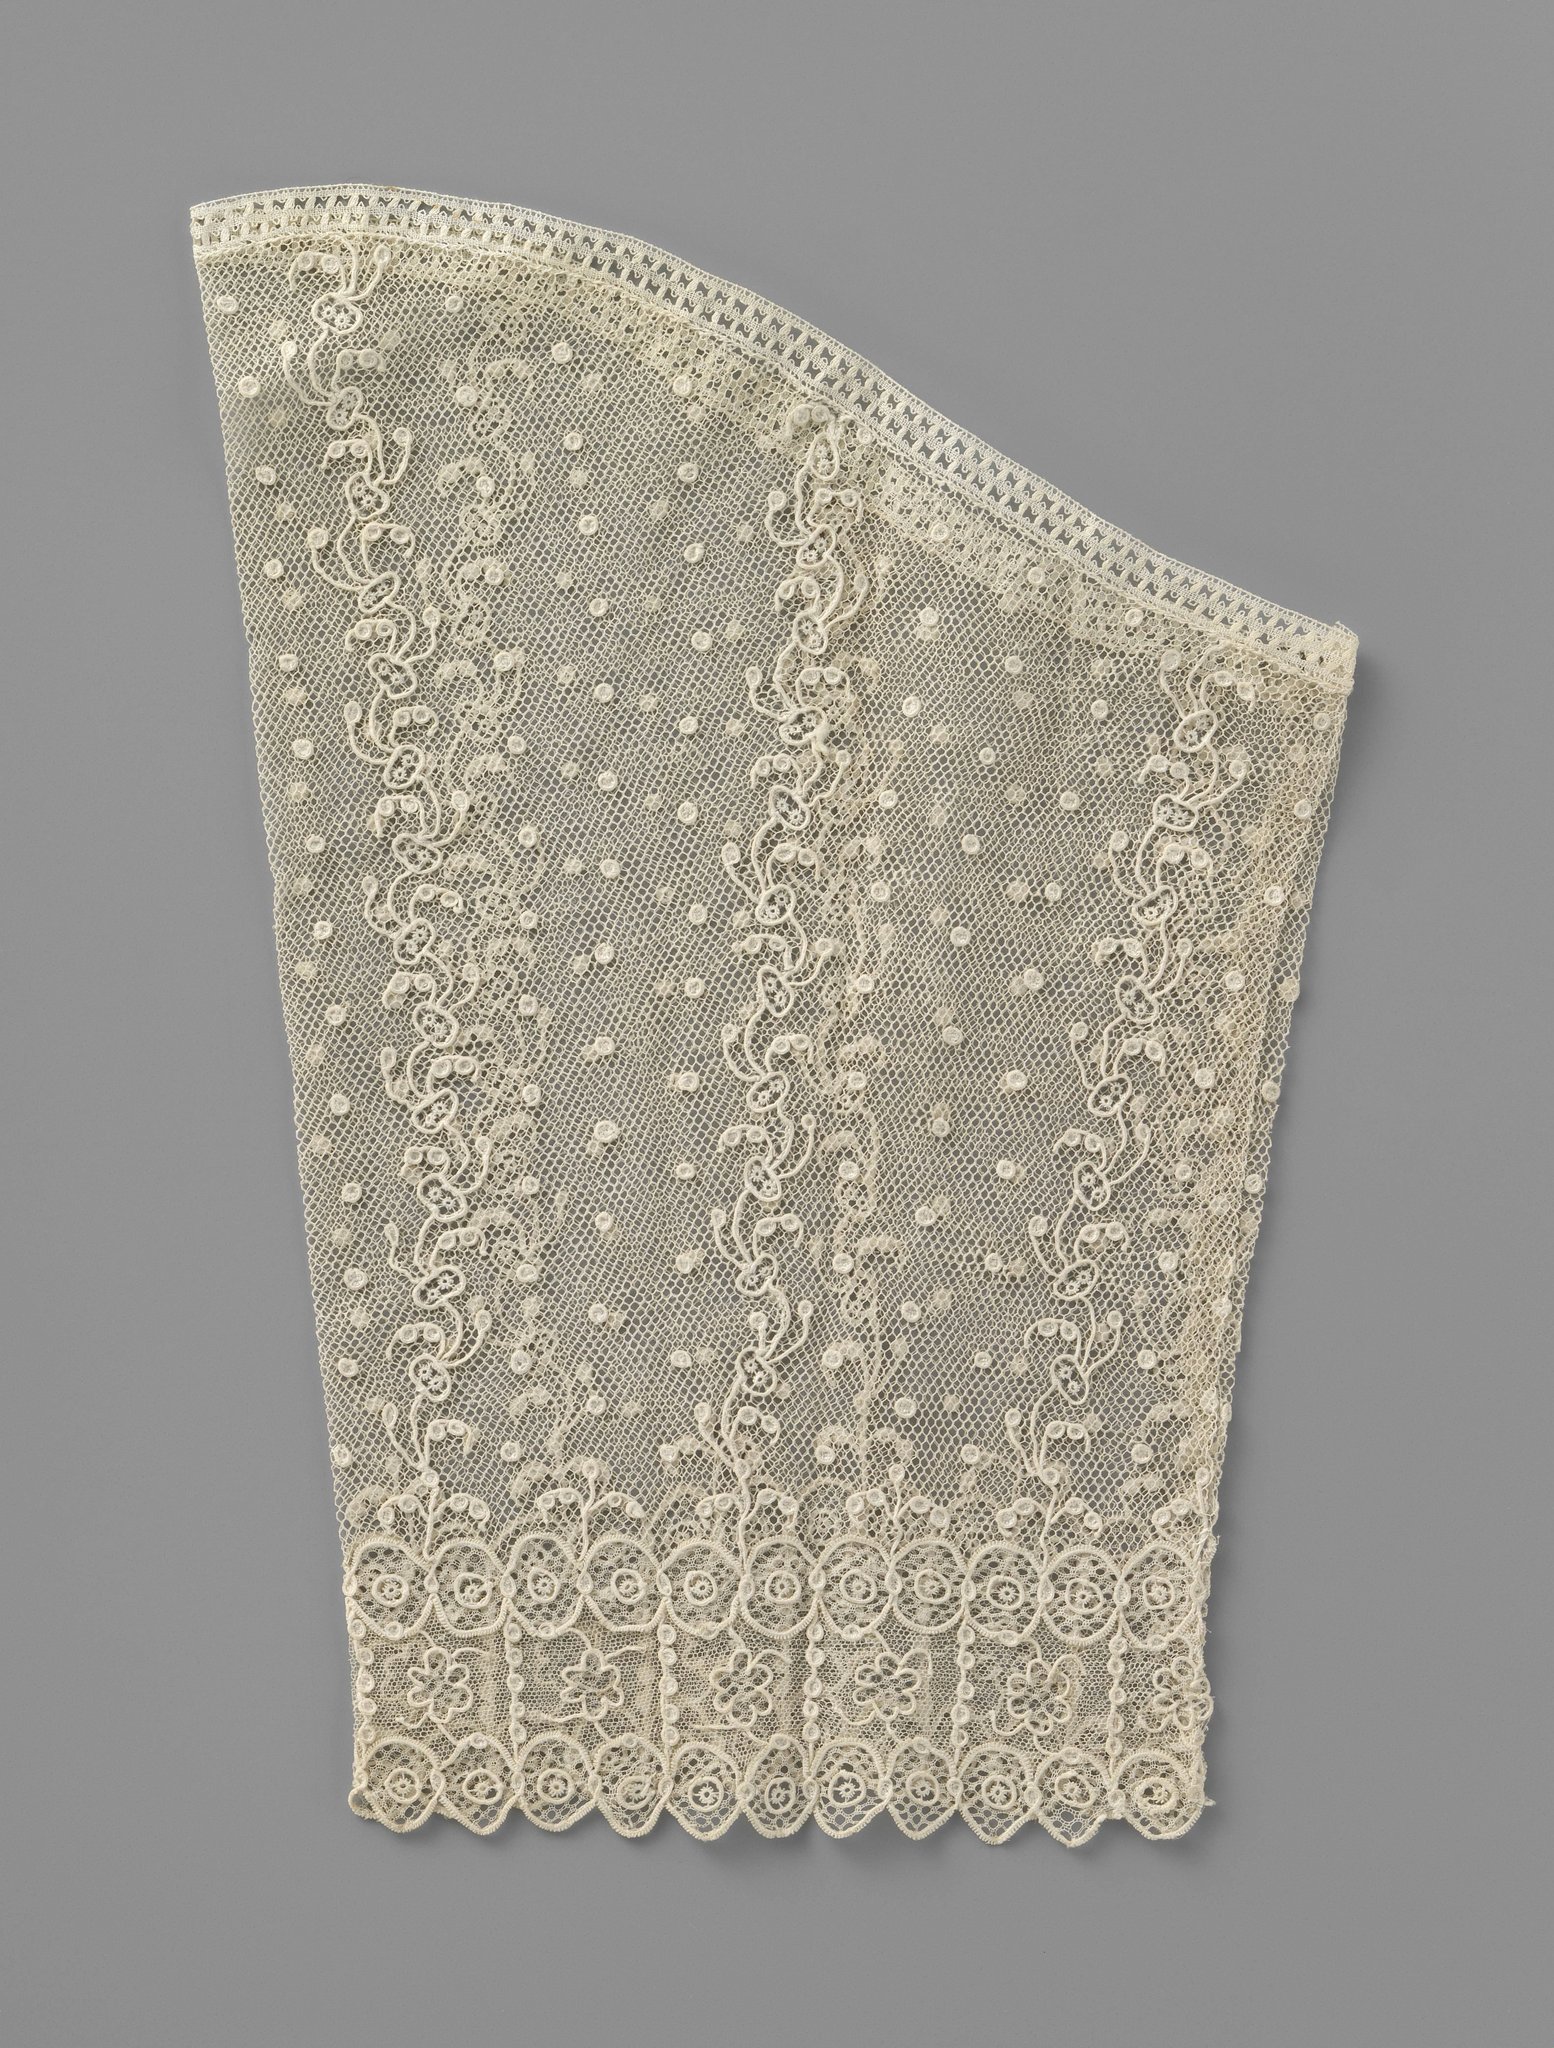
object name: sleeve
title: Mouw van naaldkant met streepjes en moesjes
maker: Anonymous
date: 1800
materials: linen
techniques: lace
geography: france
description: Korte en rechte coupe, smal toelopend naar de onderrand. Streepjes, gevormd door een slingerend takje met fijne knopjes wisselen af met tussenstroken, bezaaid met moesjes. Aan de benedenzijde loopt een dubbele rand van staande ovaaltjes waarvan de onderste tevens de schulpjes vormen. Alençon-kant.